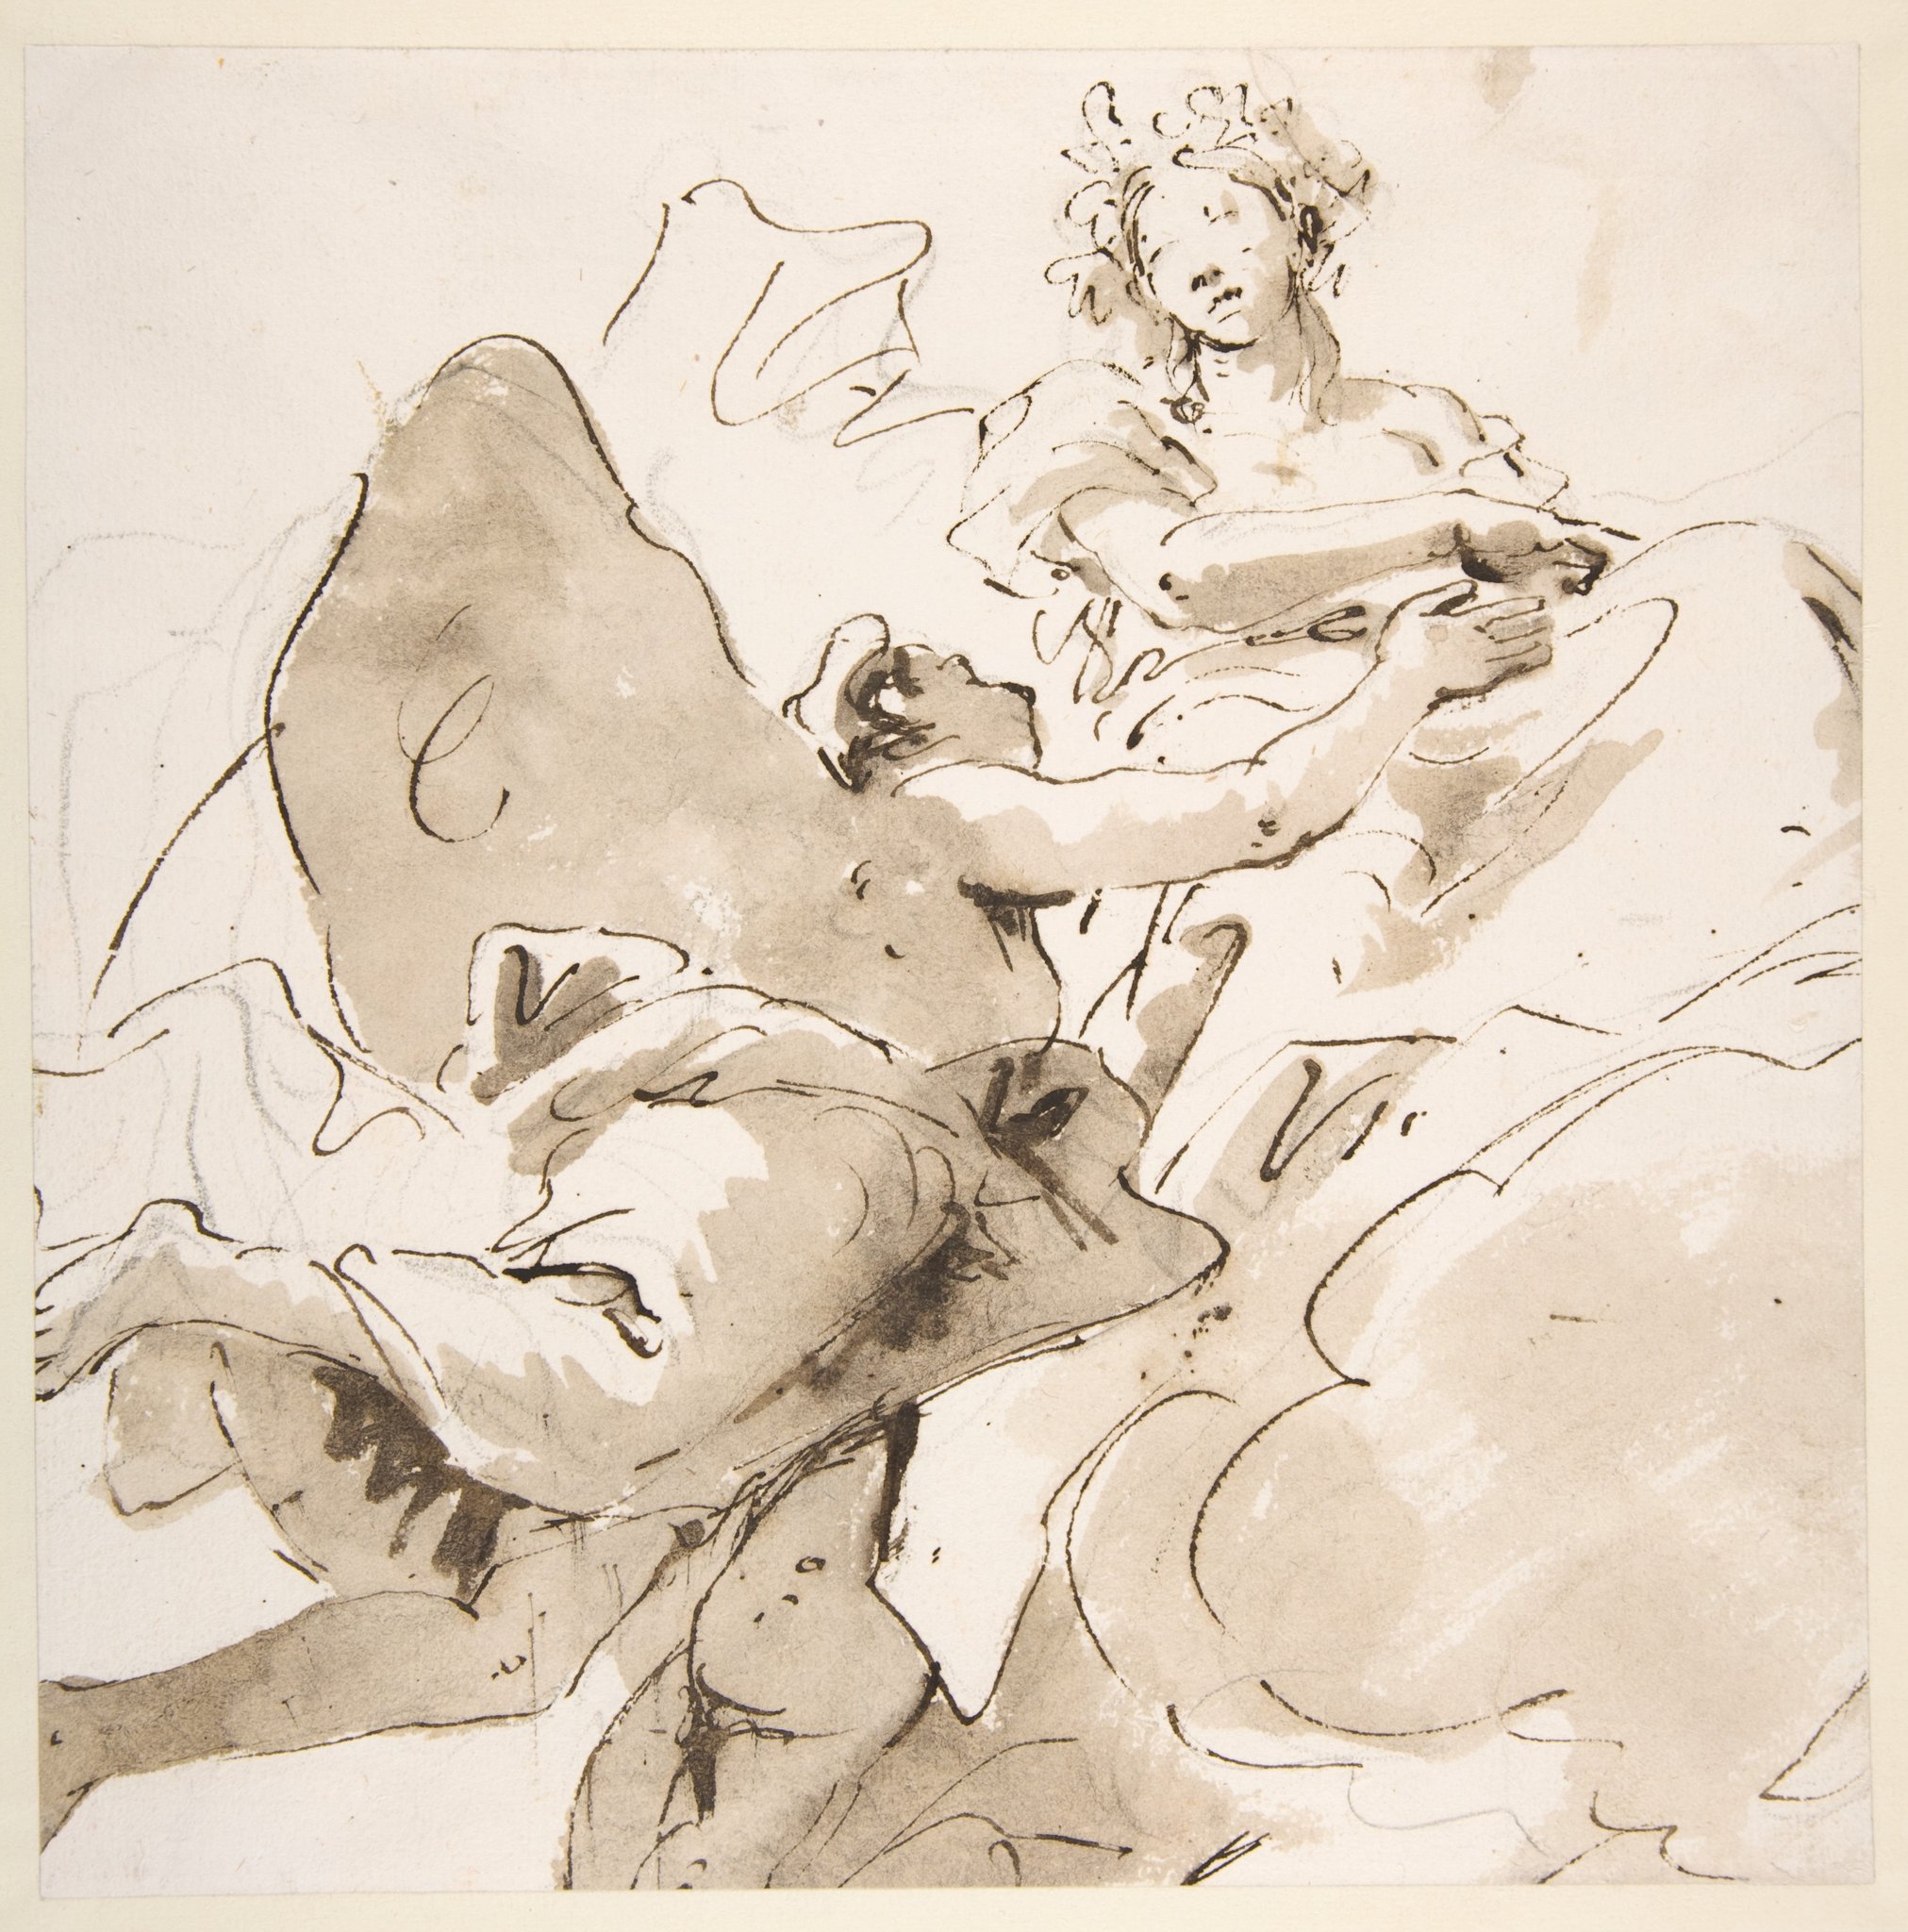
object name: drawing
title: Zephyr and Flora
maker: giovanni battista tiepolo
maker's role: artist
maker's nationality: italian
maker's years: 1696-1770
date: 1696-1770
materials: chalk, ink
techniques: brush, pen, wash